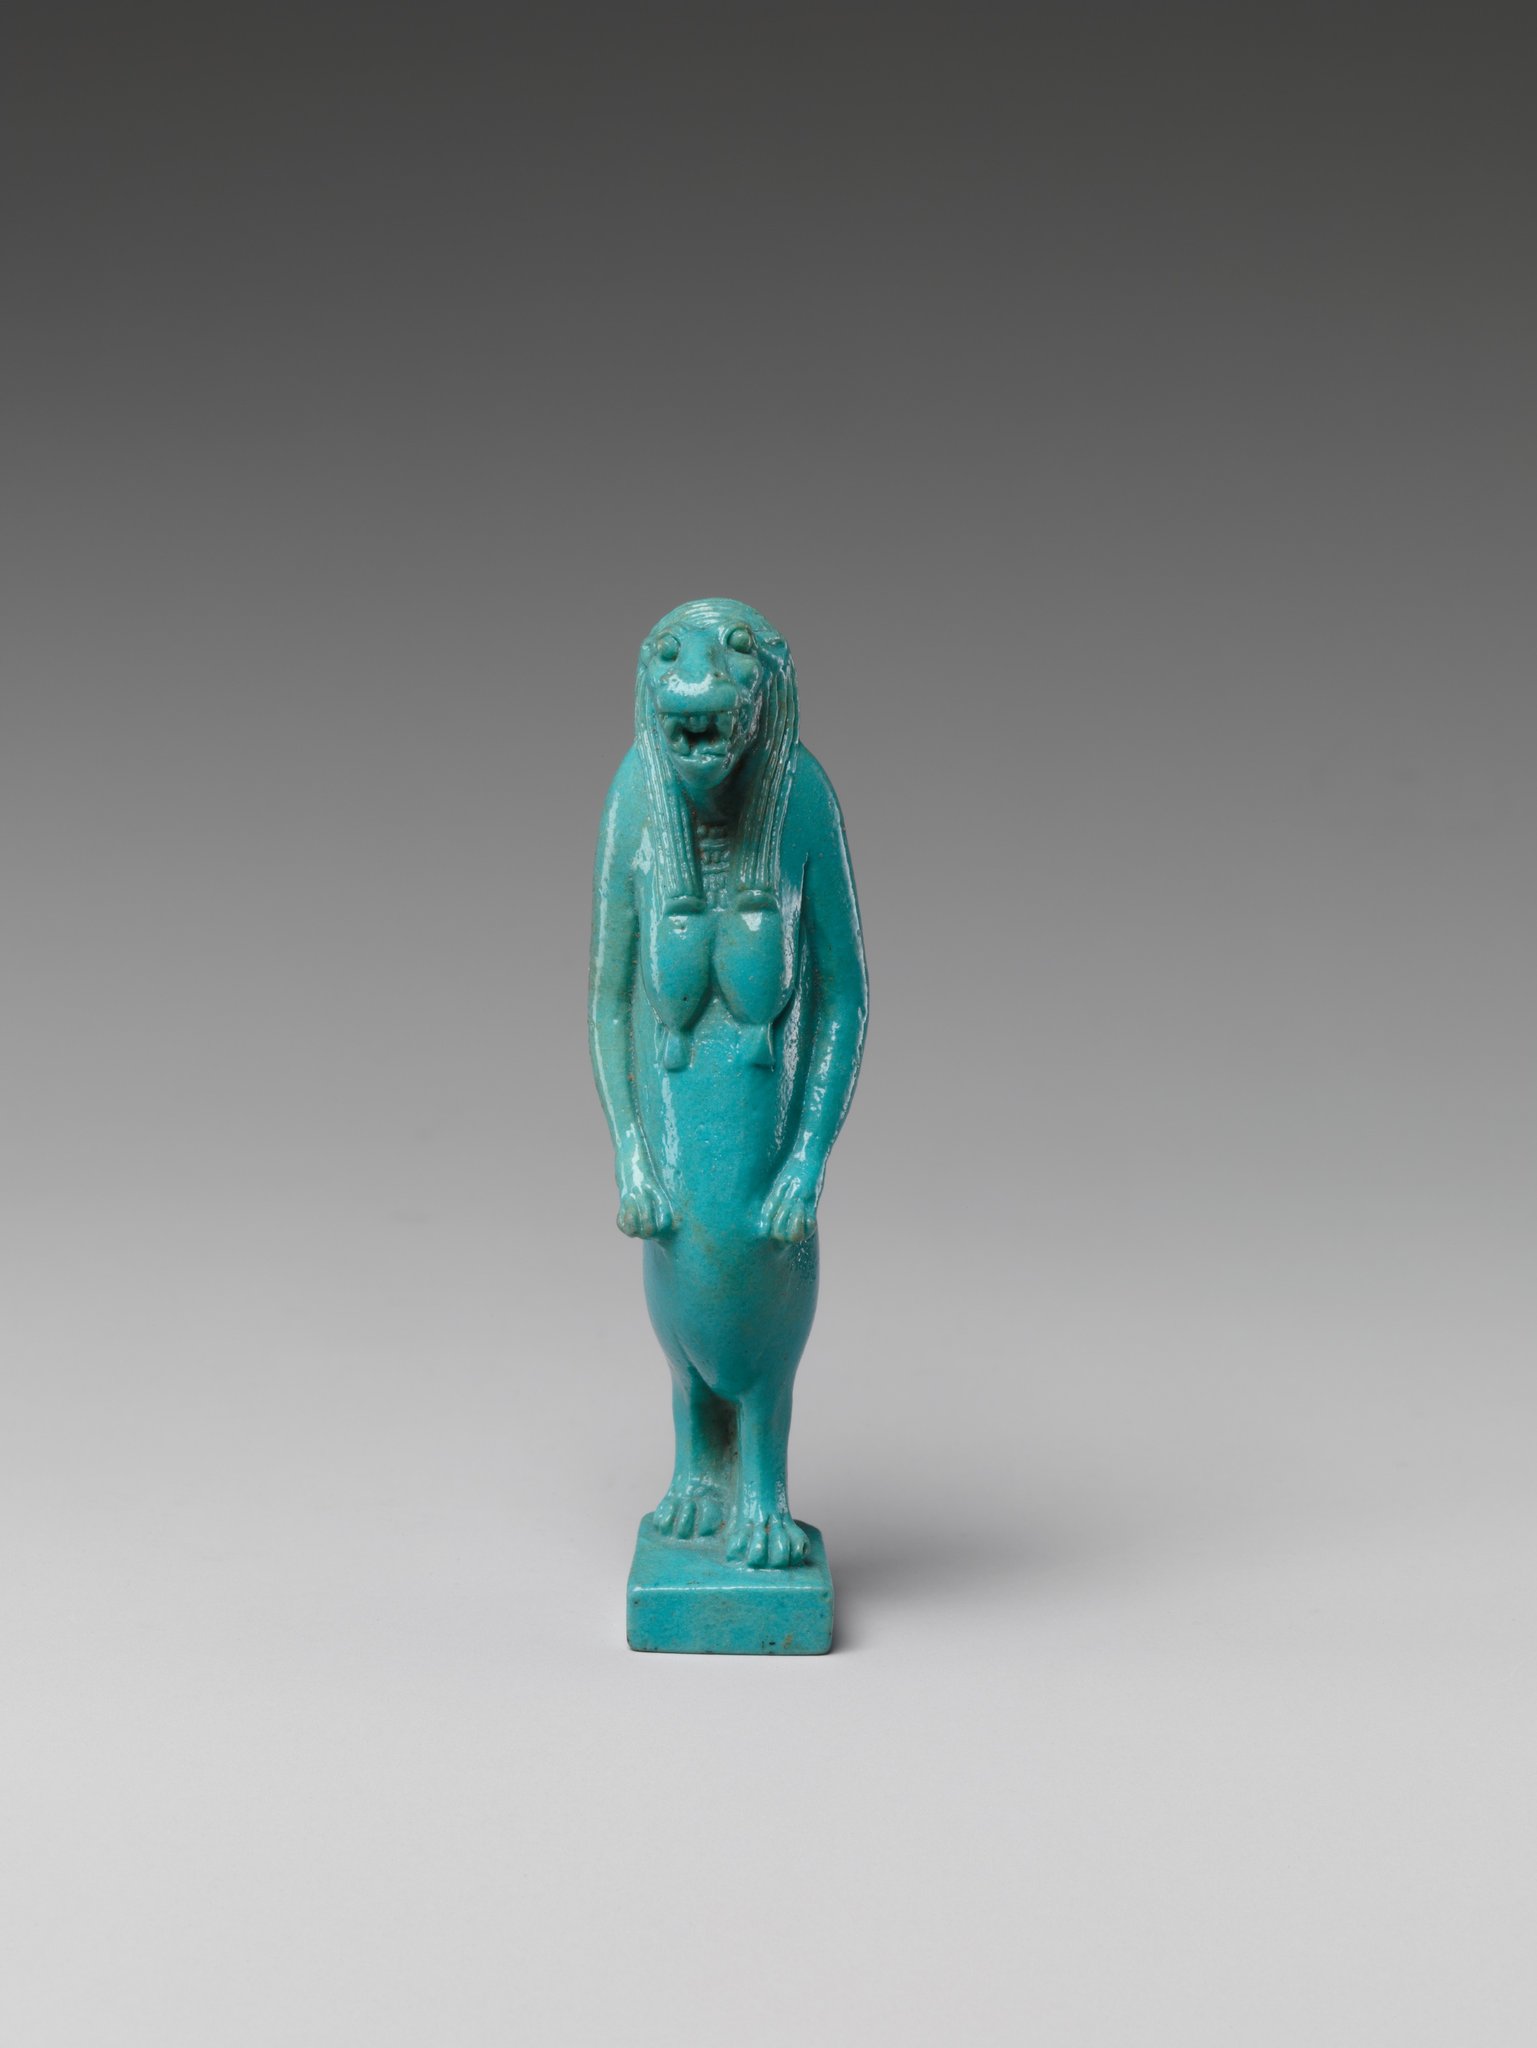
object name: taweret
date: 332-330 BCE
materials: faience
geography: egypt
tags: taweret